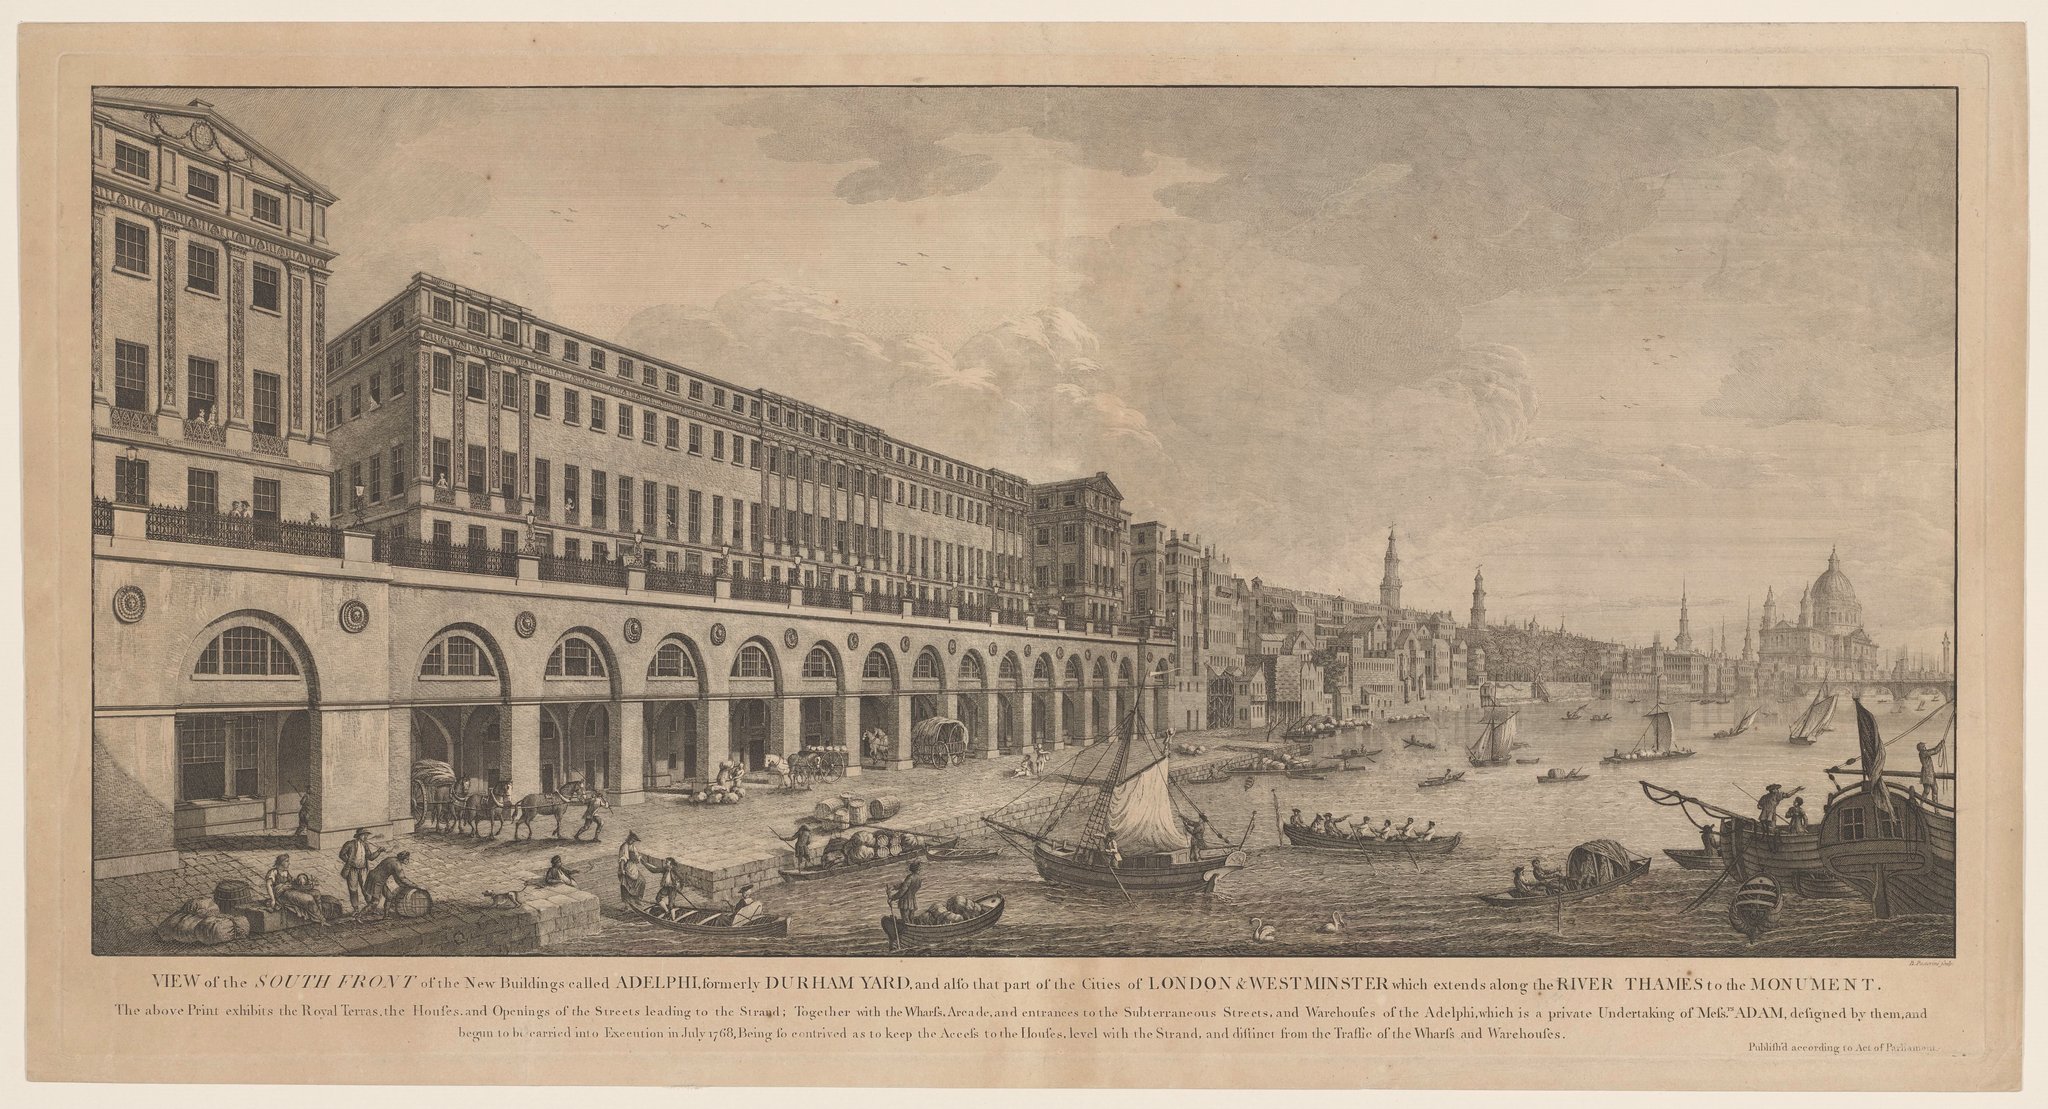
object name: print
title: View of the South Front of the New Buildings called Adelphi, formerly Durham Yard (...)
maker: benedetto pastorini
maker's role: draughtsman, print maker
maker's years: 1746-1803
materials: paper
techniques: etching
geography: italy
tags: city-view in general; 'veduta', river, church (exterior), thames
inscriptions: collector's mark: Lugt 2228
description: Gezicht op het stadsdistrict Adelphi en de Adelphi Buildings vanaf de rivier de Thames te Londen. Op de achtergrond Saint Paul's Cathedral. Titel en onderschrift in ondermarge in het Engels.